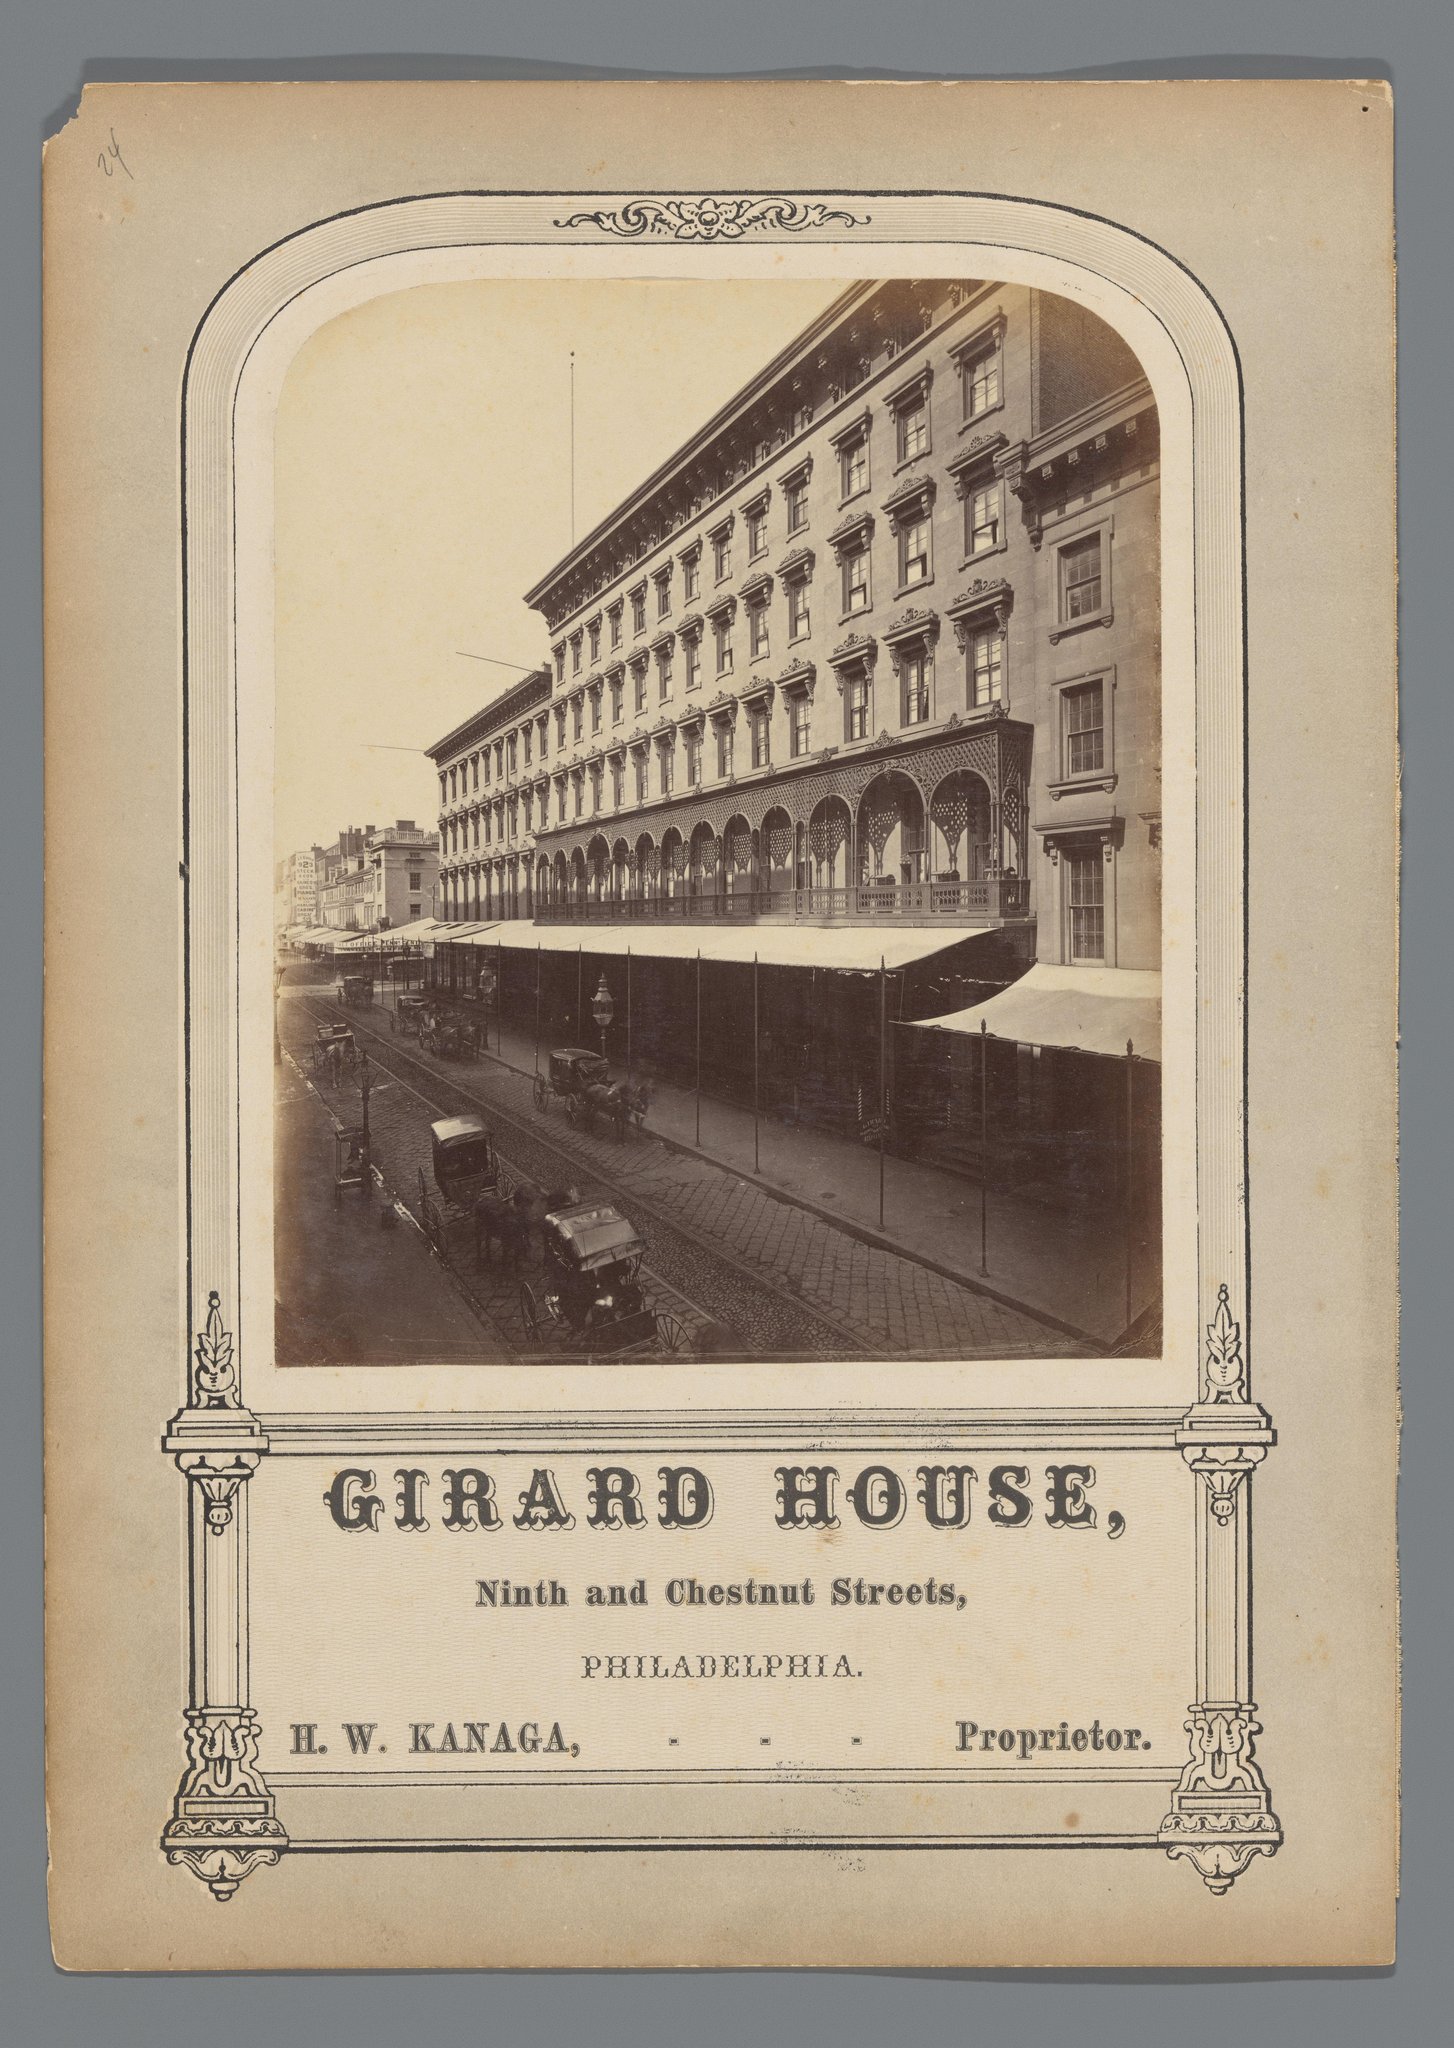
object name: photograph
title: Façade van Girard House (hotel) (eigenaar: H.W. Kanaga), Ninth and Chestnut Streets, Philadelphia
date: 1871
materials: cardboard, paper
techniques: albumen print, printed materials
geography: philadelphia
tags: philadelphia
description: Pagina uit Gallery of Arts and Manufactures of Philadelphia.